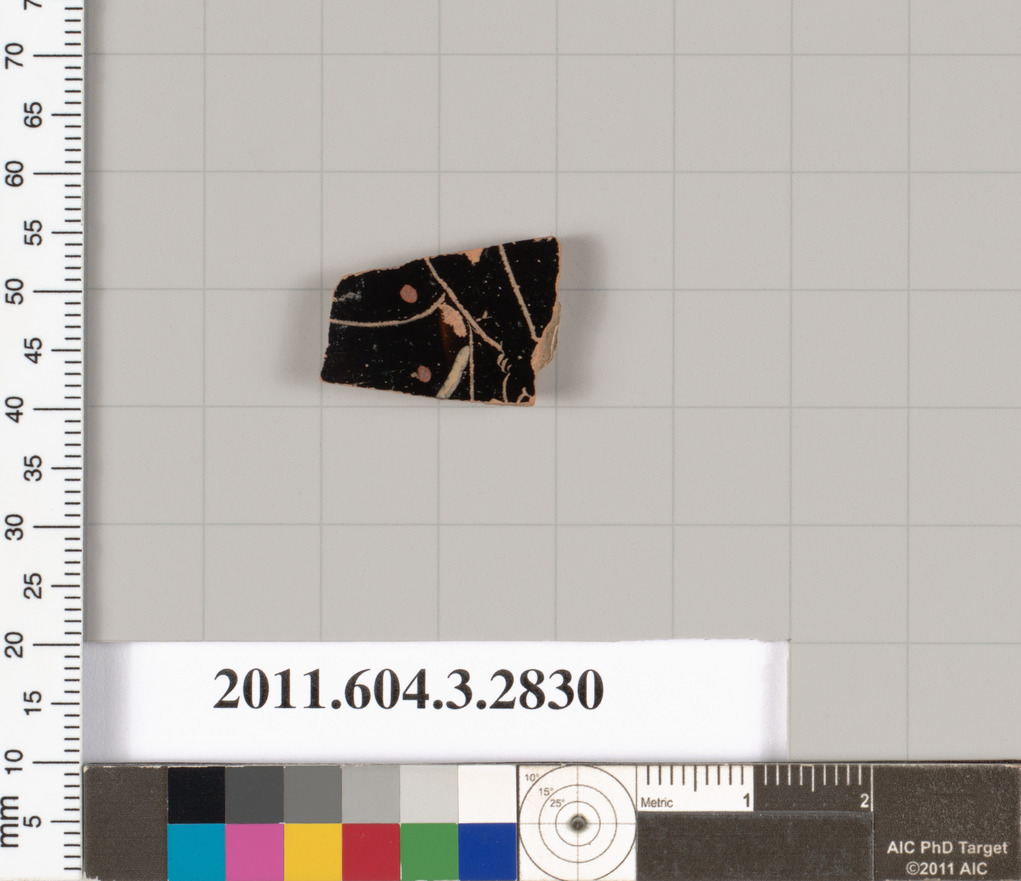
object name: oinochoe or olpe fragment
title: Terracotta fragment of an oinochoe (jug) or an olpe (jug)?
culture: greek, attic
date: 534-468 BCE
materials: terracotta